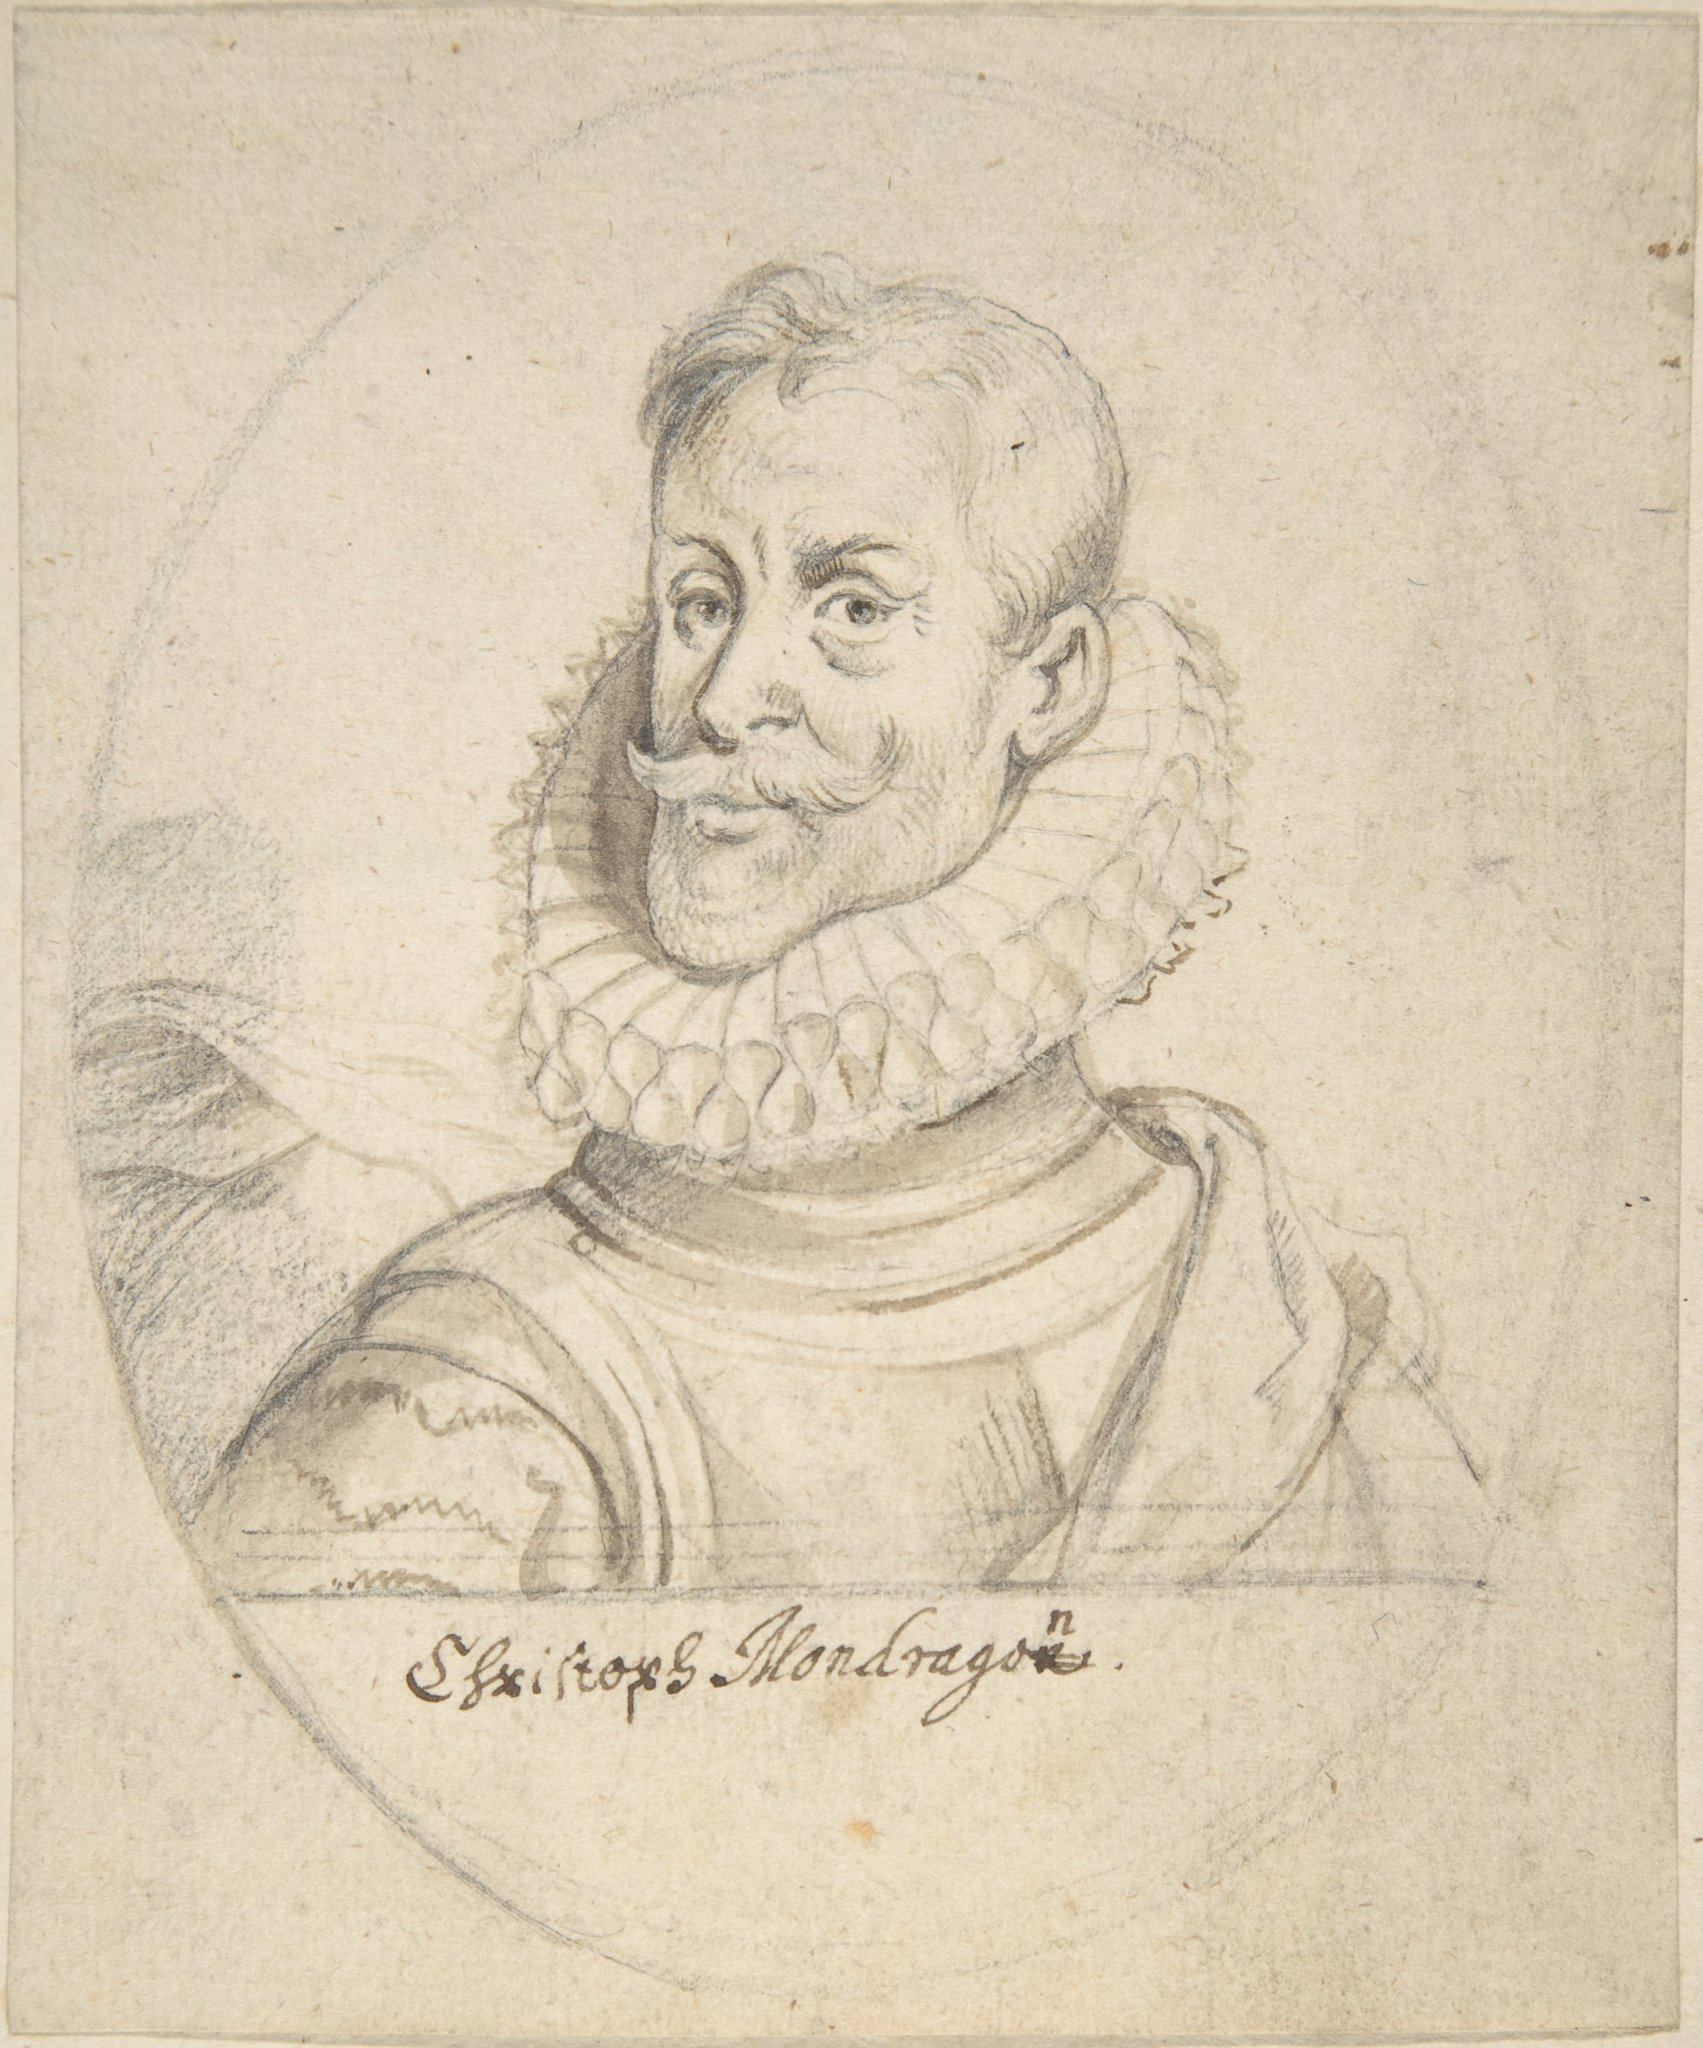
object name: drawing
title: Portrait of Christoph Mondragon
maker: anonymous, flemish, 17th century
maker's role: artist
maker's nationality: flemish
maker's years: 1600-1700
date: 1601-1700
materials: board, chalk, down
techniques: brush, incising, wash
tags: men,portraits